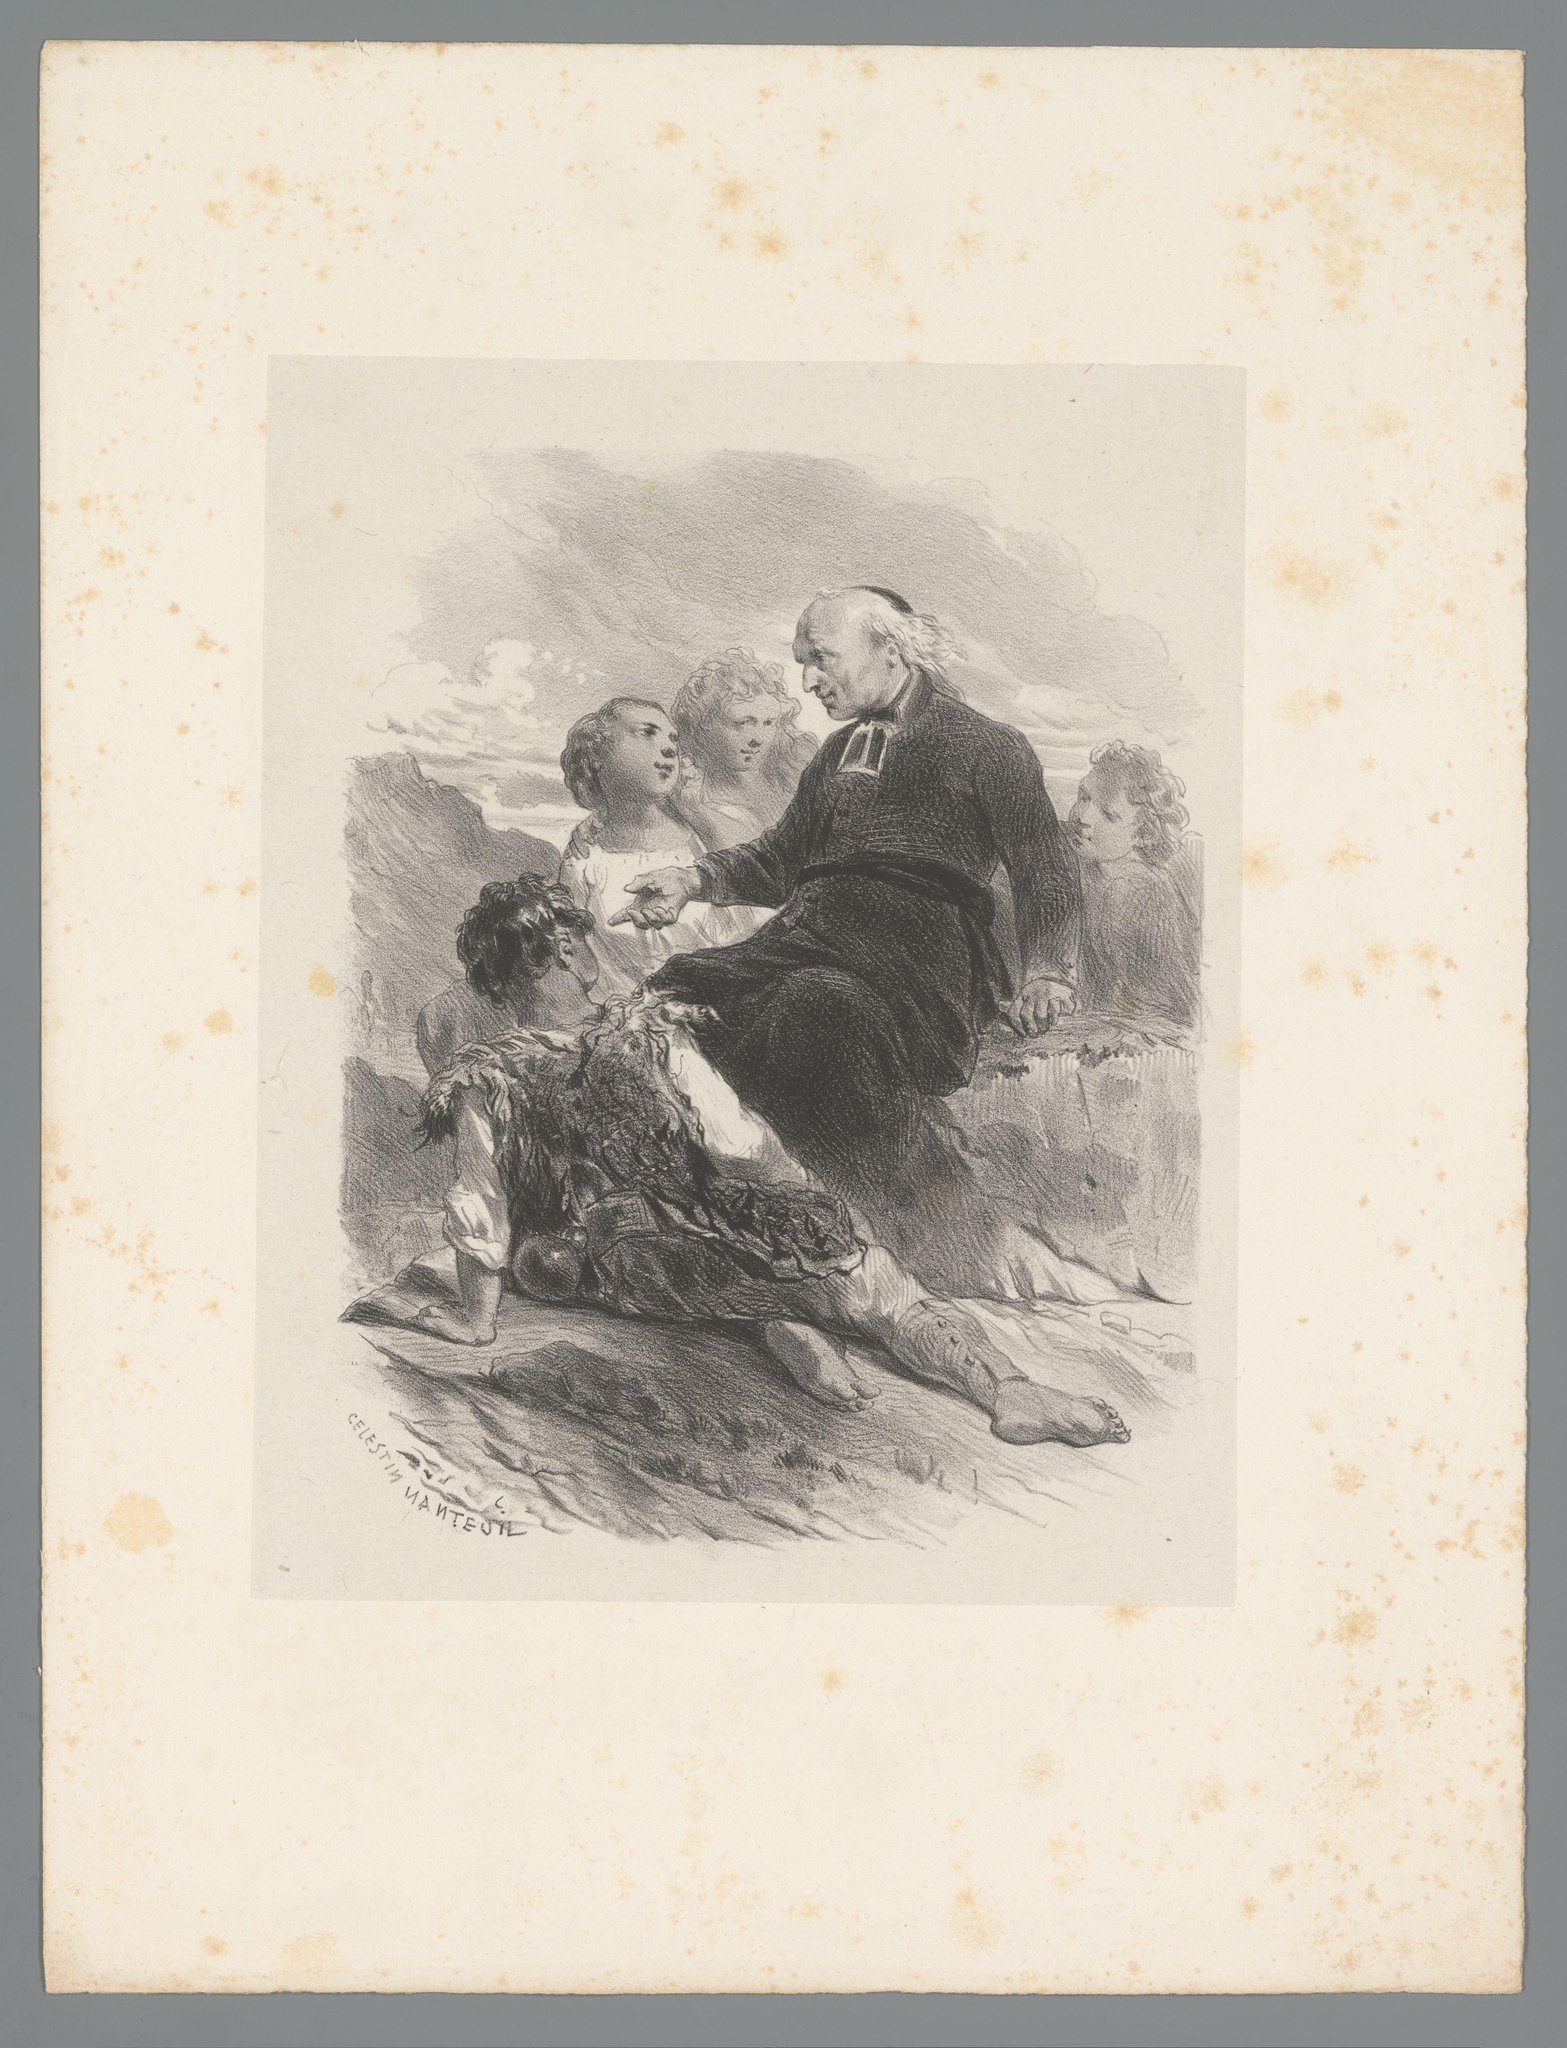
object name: print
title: Geestelijke zittend op een rots omringd door kinderen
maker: célestin françois nanteuil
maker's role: print maker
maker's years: 1813-1873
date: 1823-1873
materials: paper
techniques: lithograph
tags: child, priests ~ hierarchy of priests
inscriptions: collector's mark: Lugt 964